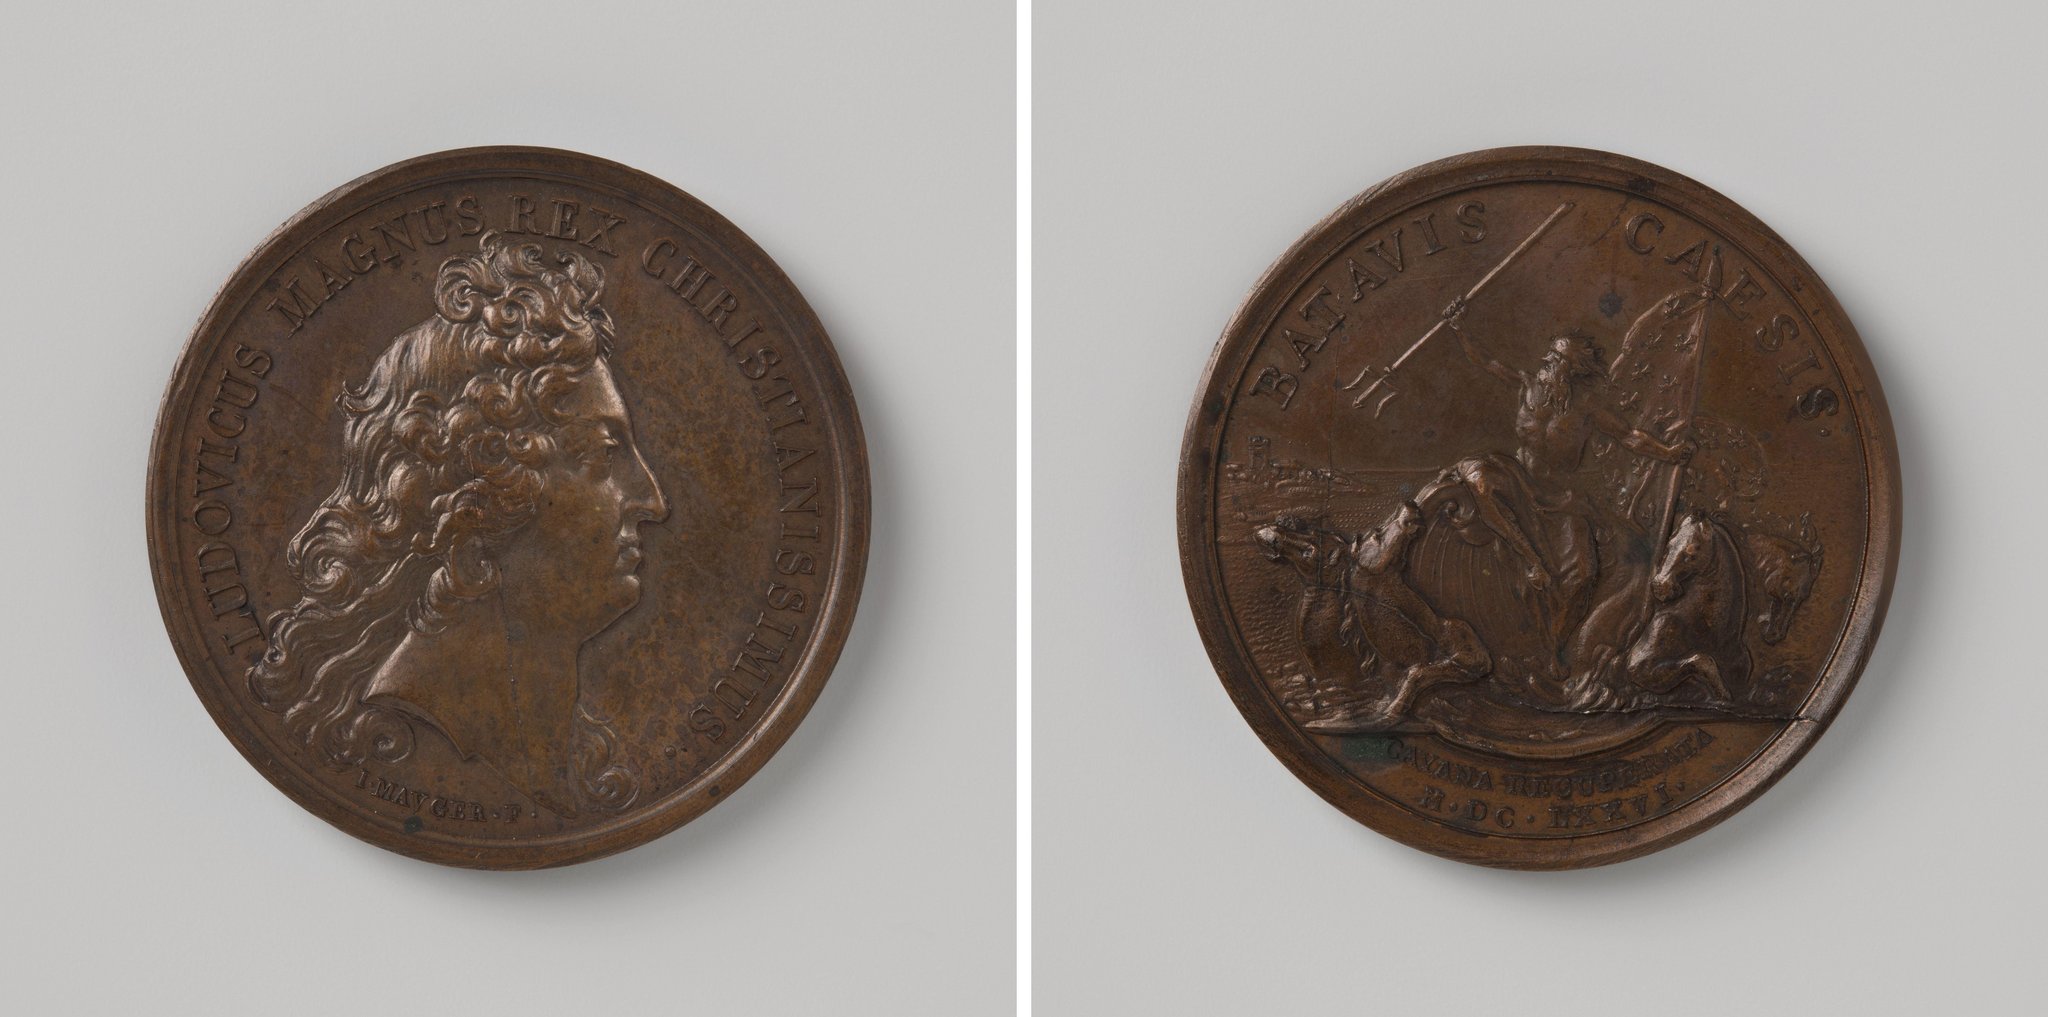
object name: history medal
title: Cayenne door de Fransen heroverd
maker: jean mauger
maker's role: medailleur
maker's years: 1648-1722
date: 1699-1703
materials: bronze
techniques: striking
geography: paris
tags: lodewijk xiv (koning van frankrijk)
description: Bronzen penning. Voorzijde: borststuk man binnen omschrift. Keerzijde: Neptunus met drietand en vaandel met lelies zittend op zijn wagen binnen omschrift.